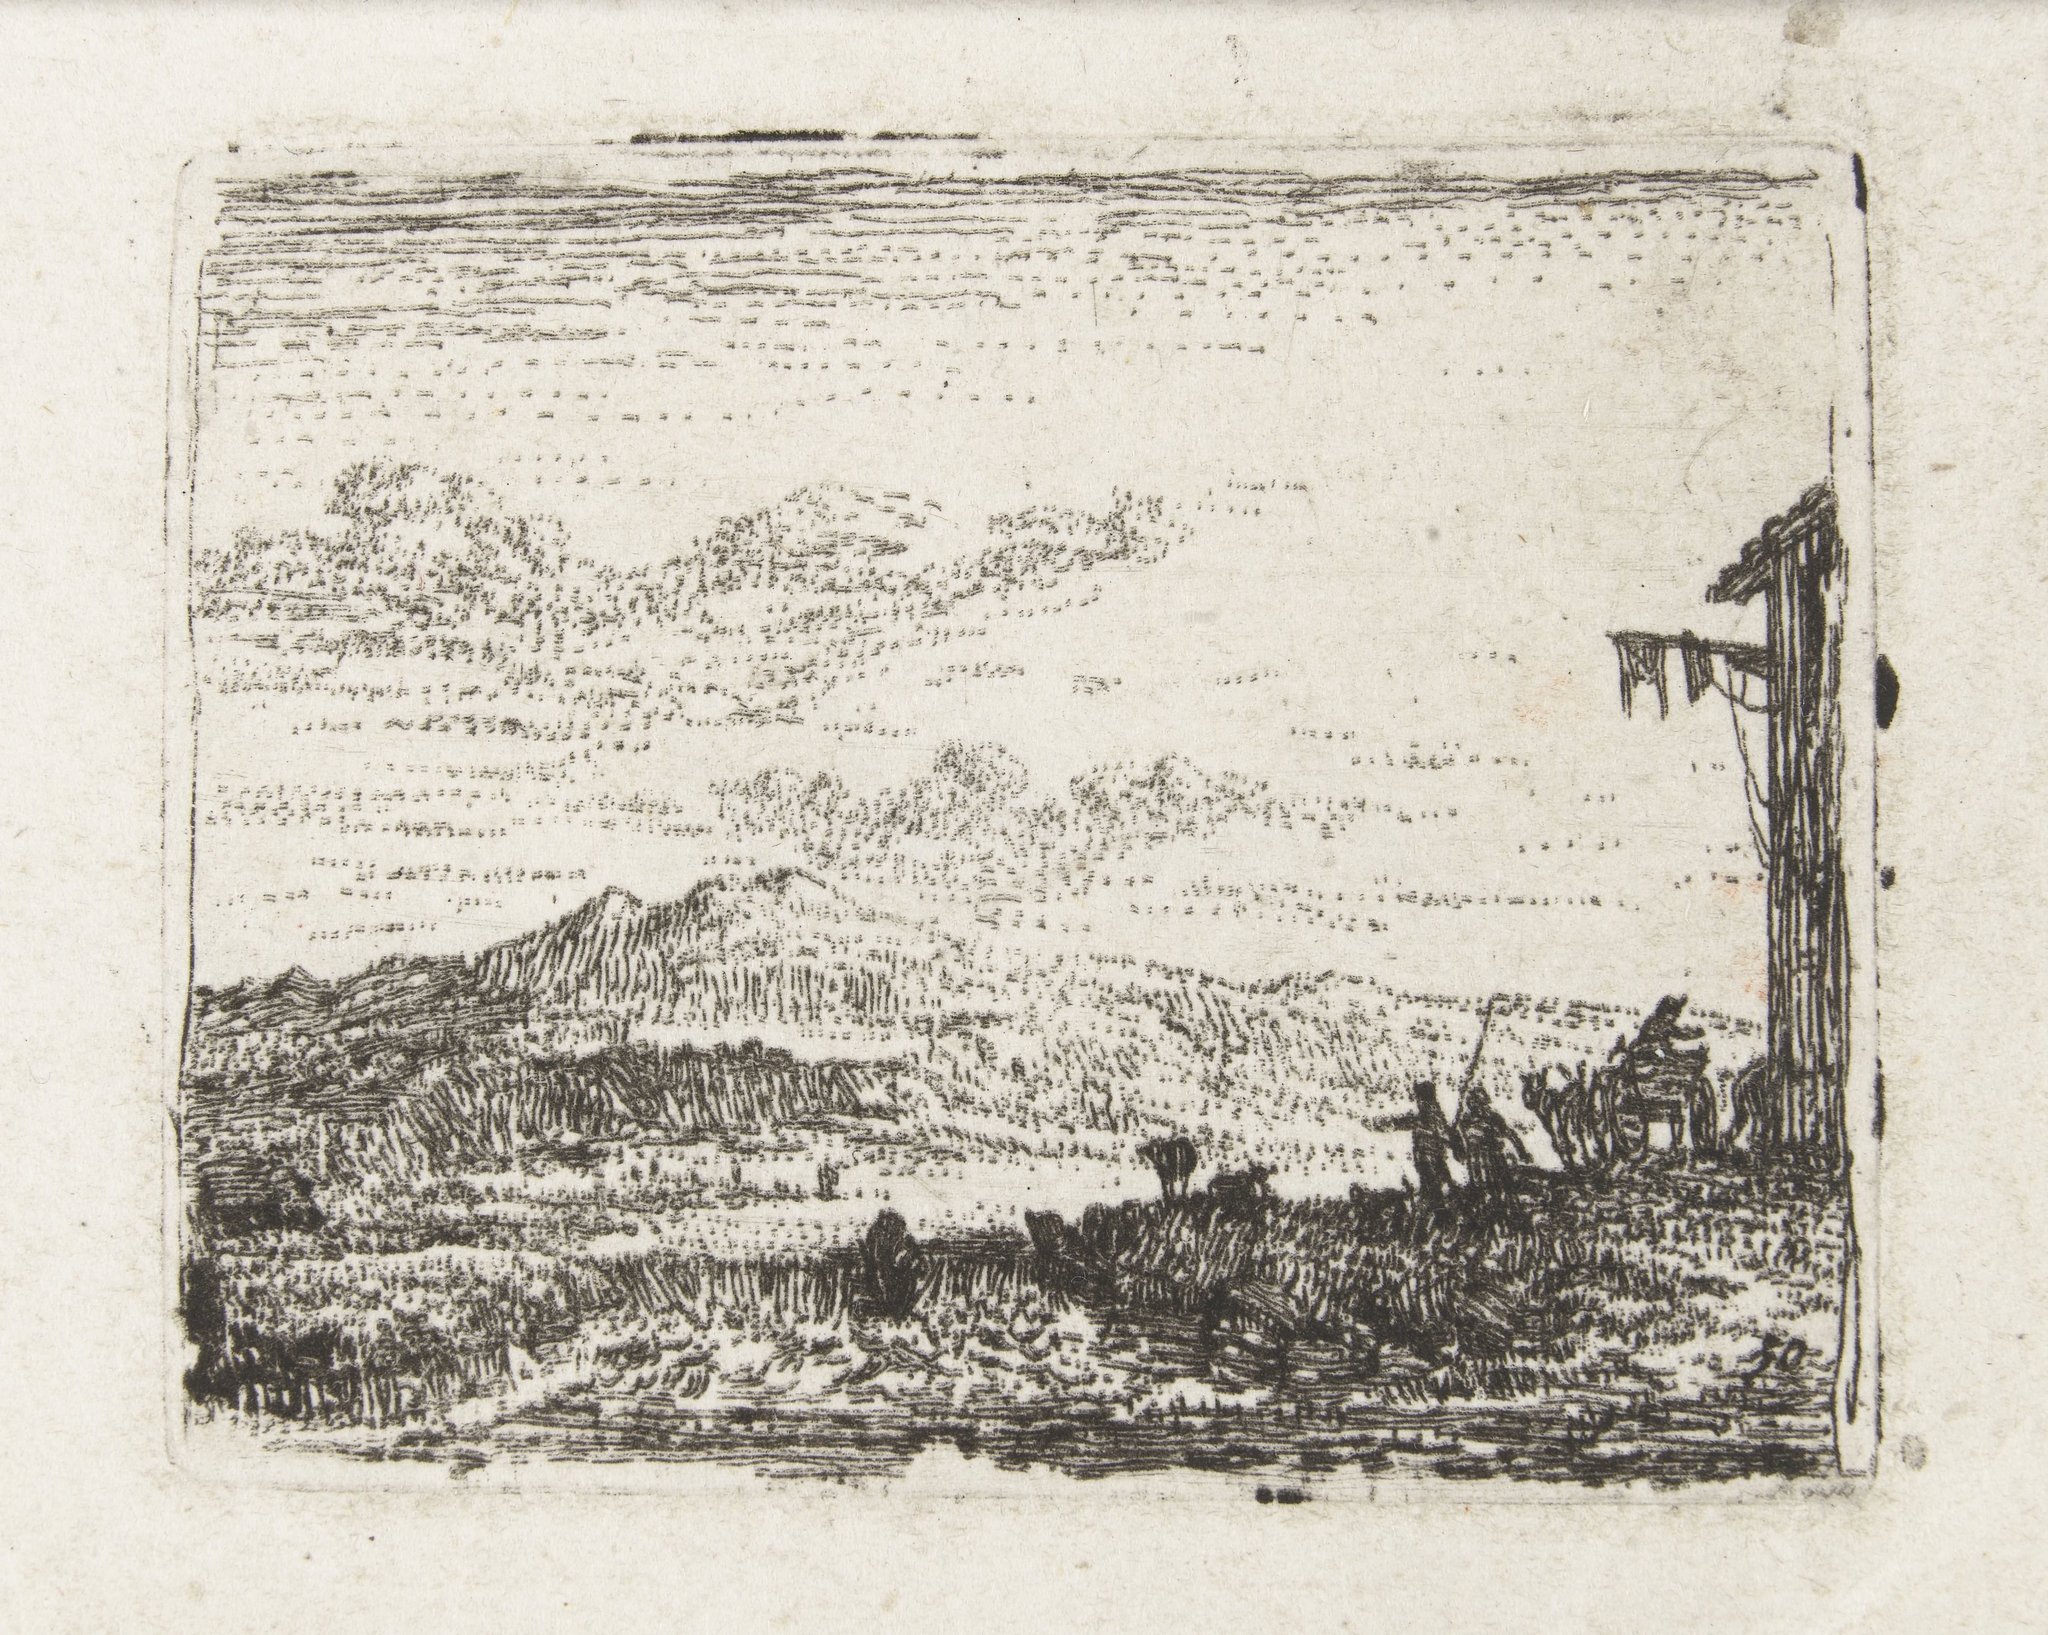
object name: print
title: Kleine landschappen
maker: karel du jardin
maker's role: draughtsman, painter, print maker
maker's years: 1626-1678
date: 1652-1659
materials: paper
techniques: etching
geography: netherlands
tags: low hill country, inn, coffee-house, public house, etc.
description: Maakt deel uit van blad met acht kleine etsen